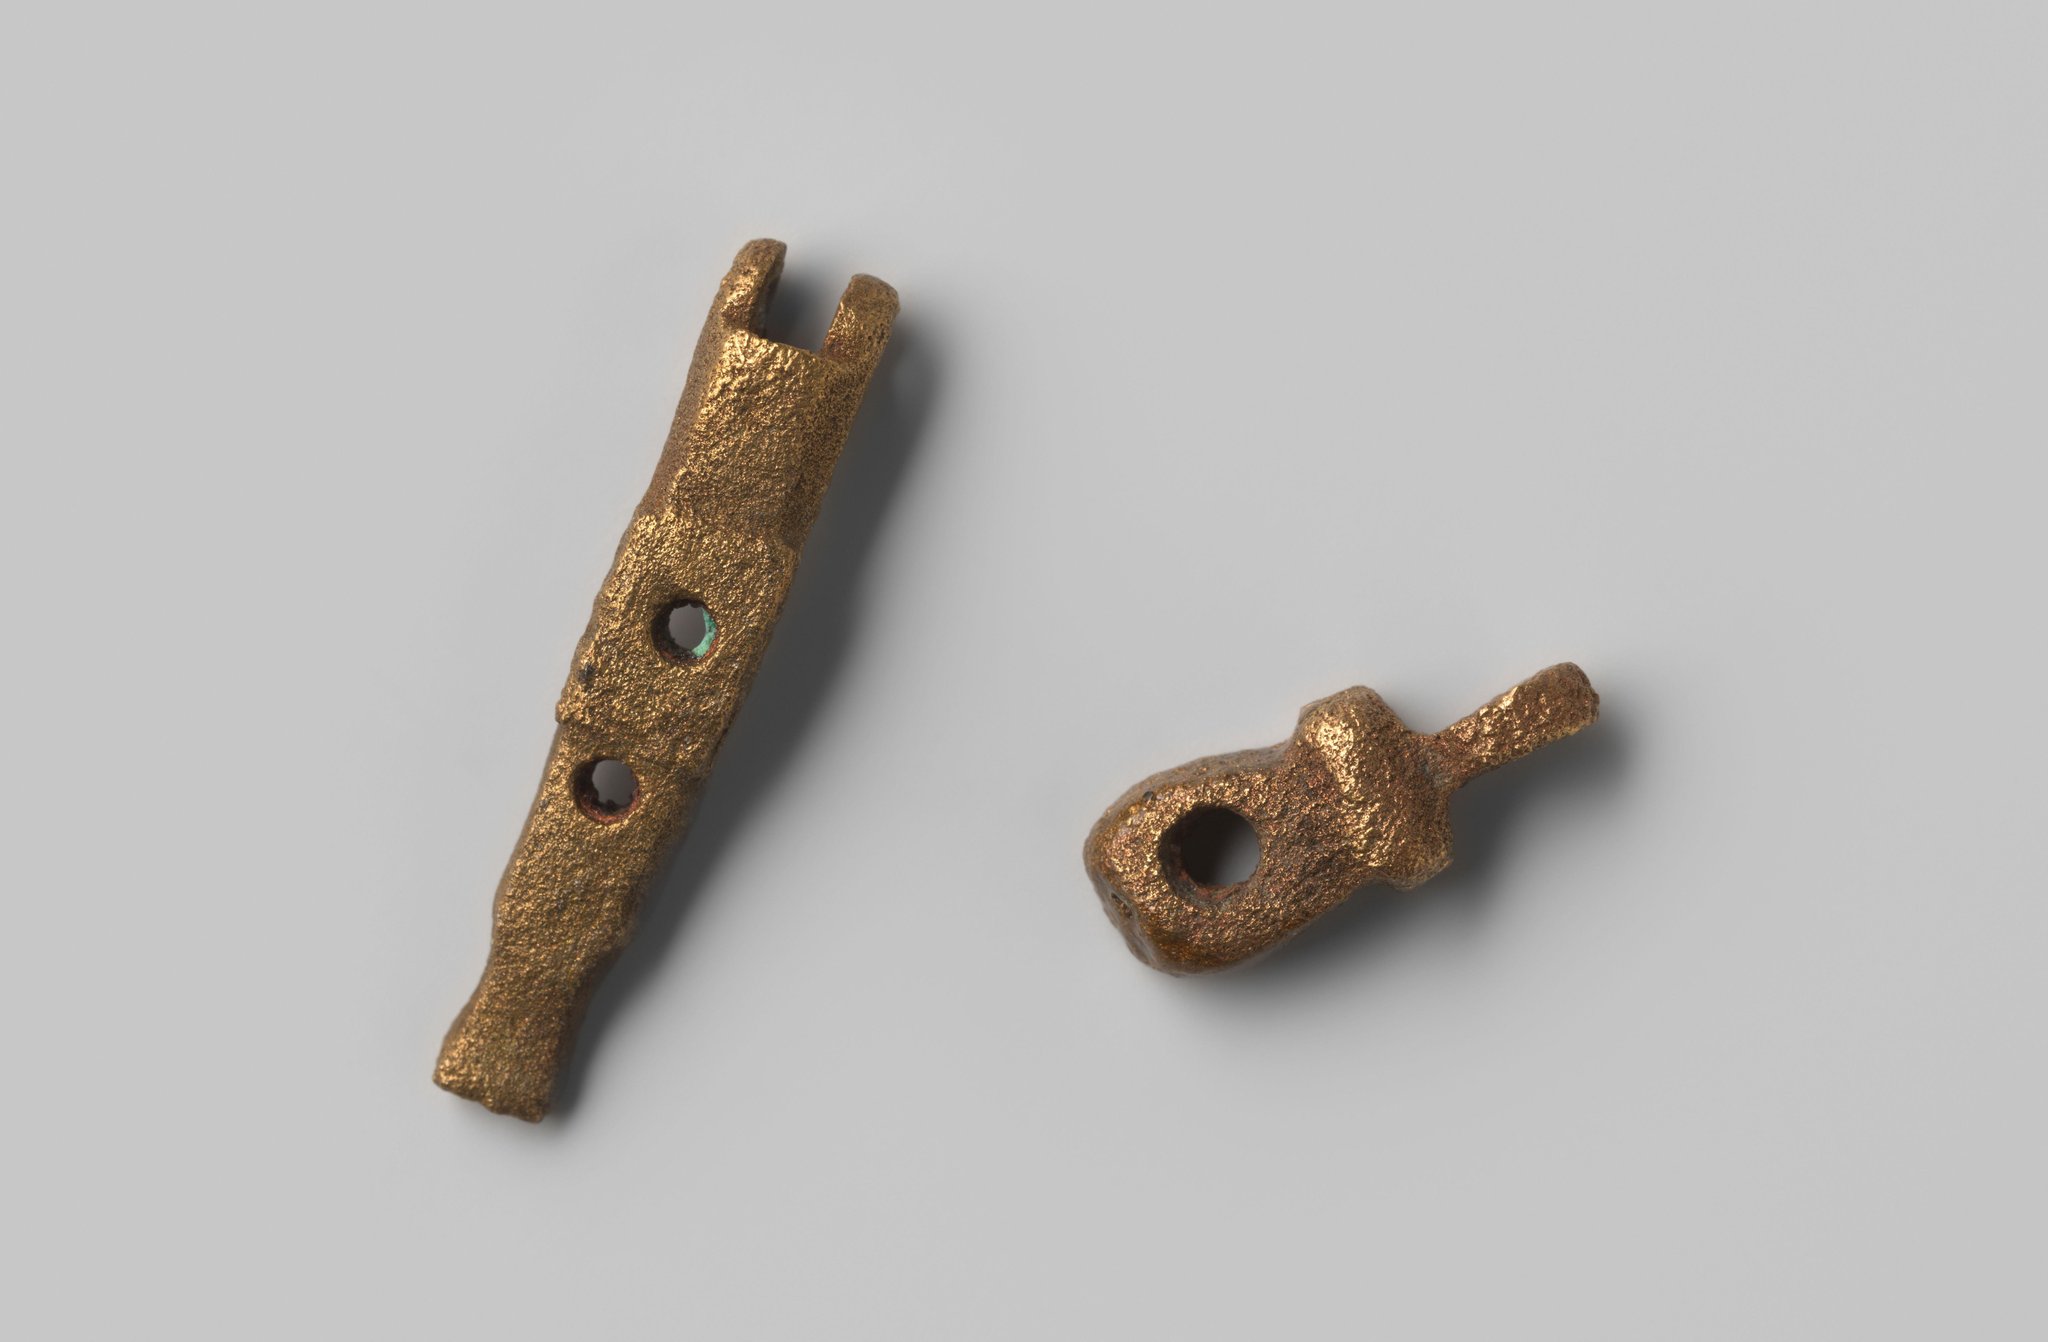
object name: sluitgewicht, pijlgewicht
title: Onderdelen slot van een sluitgewicht uit het wrak van de Oost-Indiëvaarder Hollandia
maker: Anonymous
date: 1700-1743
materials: copper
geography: netherlands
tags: verenigde oostindische compagnie, hollandia (schip), annet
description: Weight, cupweight, locks and hinges; fragm of lock, id. NG 1980-27H737.